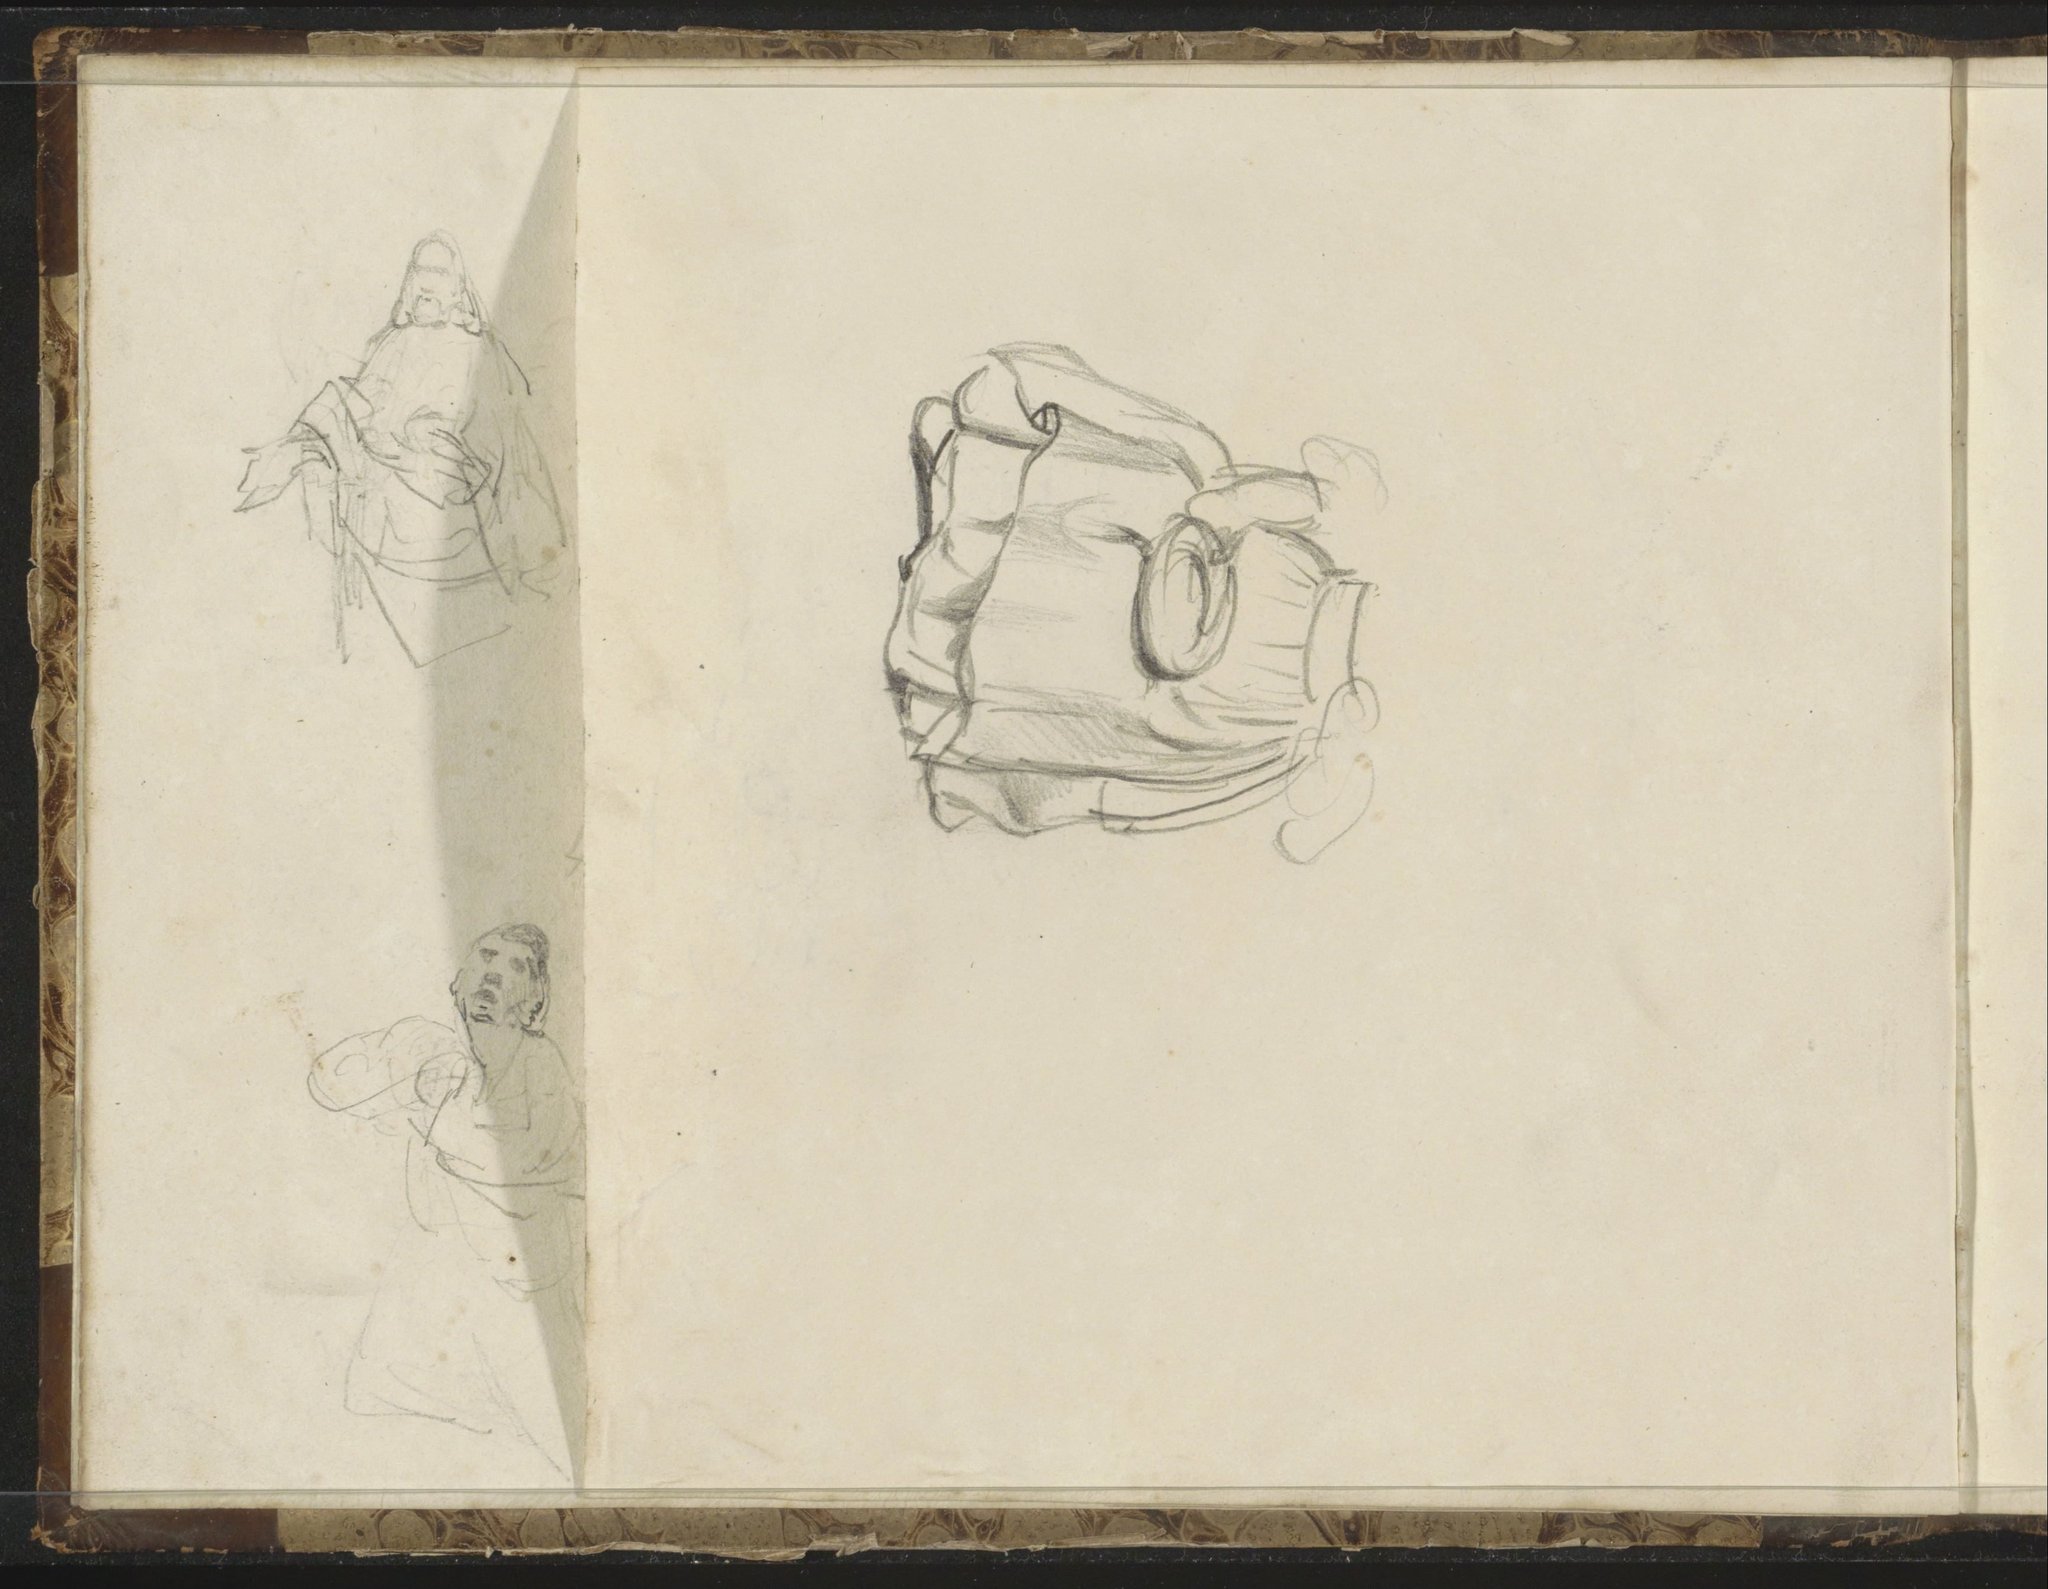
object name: sketchbook leaf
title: Zittende vrouw of meisje in een rok met schort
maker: willem hendrik schmidt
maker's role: draughtsman, painter, print maker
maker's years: 1809-1849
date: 1819-1849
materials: paper, pencil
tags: sitting figure - aa - female human figure, apron, skirt (+ women's clothes)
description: De vrouw of het meisje heeft een schaal op haar schoot. Blad 3 verso uit een schetsboek met 52 bladen.